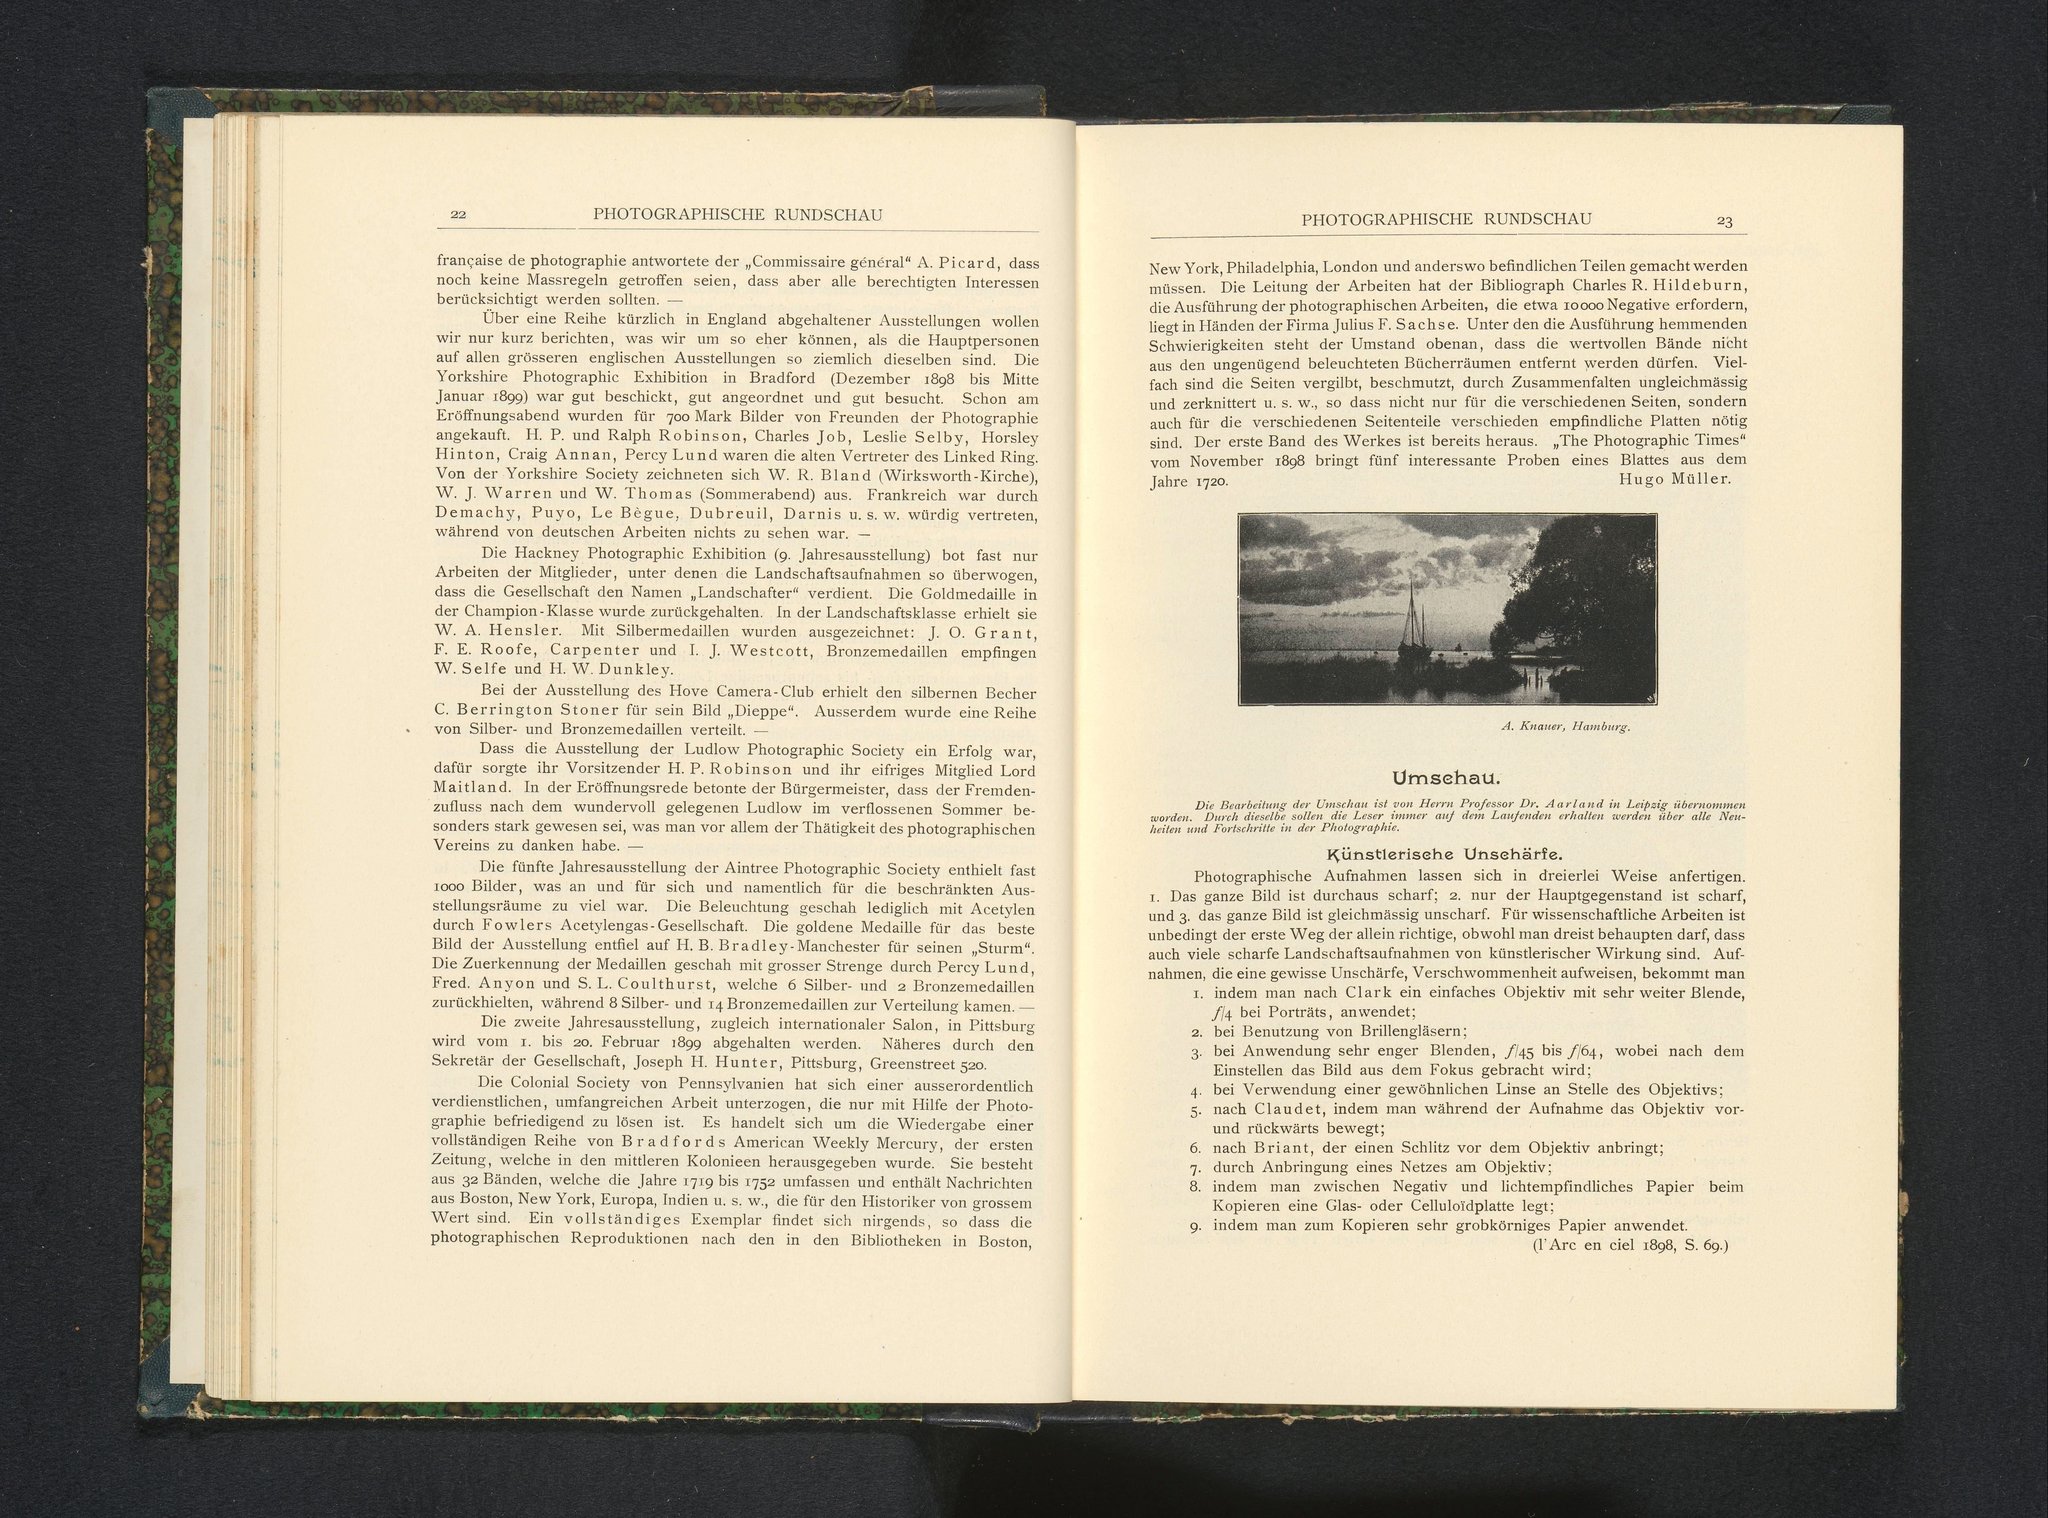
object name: photomechanical print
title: Gezicht op een zeilschip op het water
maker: a. knauer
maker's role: fotograaf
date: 1894-1899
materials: paper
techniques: autotype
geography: berlin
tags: sailing-ship, sailing-boat, landscapes with waters, waterscapes, seascapes (in the temperate zone)